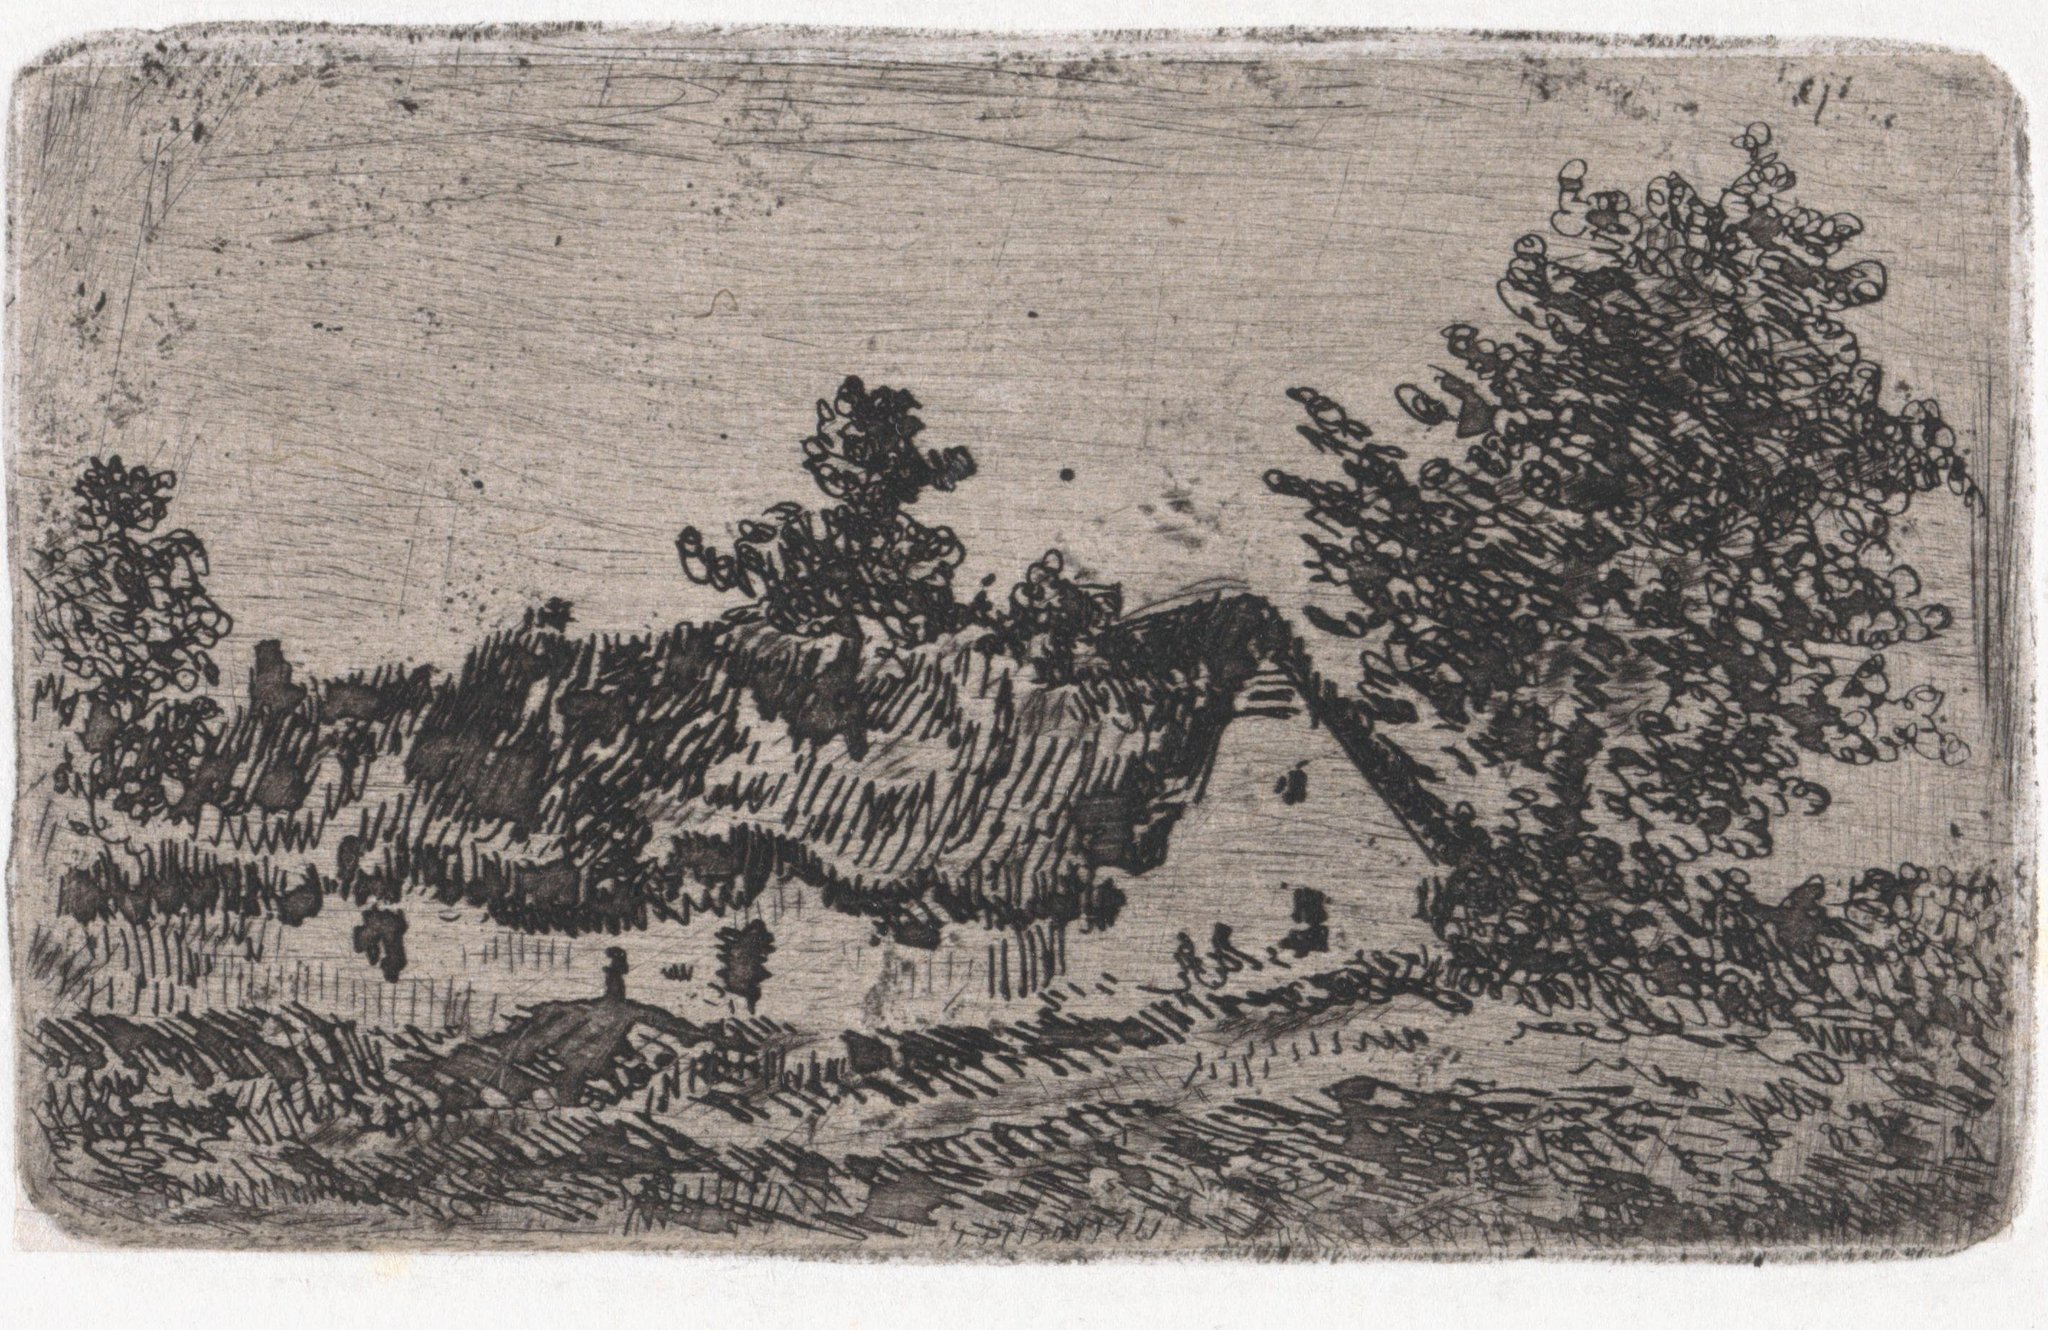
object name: print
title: Rietgedekt huis in een landschap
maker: arnoud schaepkens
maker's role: print maker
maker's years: 1816-1904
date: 1855-1904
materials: paper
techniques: drypoint, etching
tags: cottage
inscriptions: collector's mark: Lugt 2228